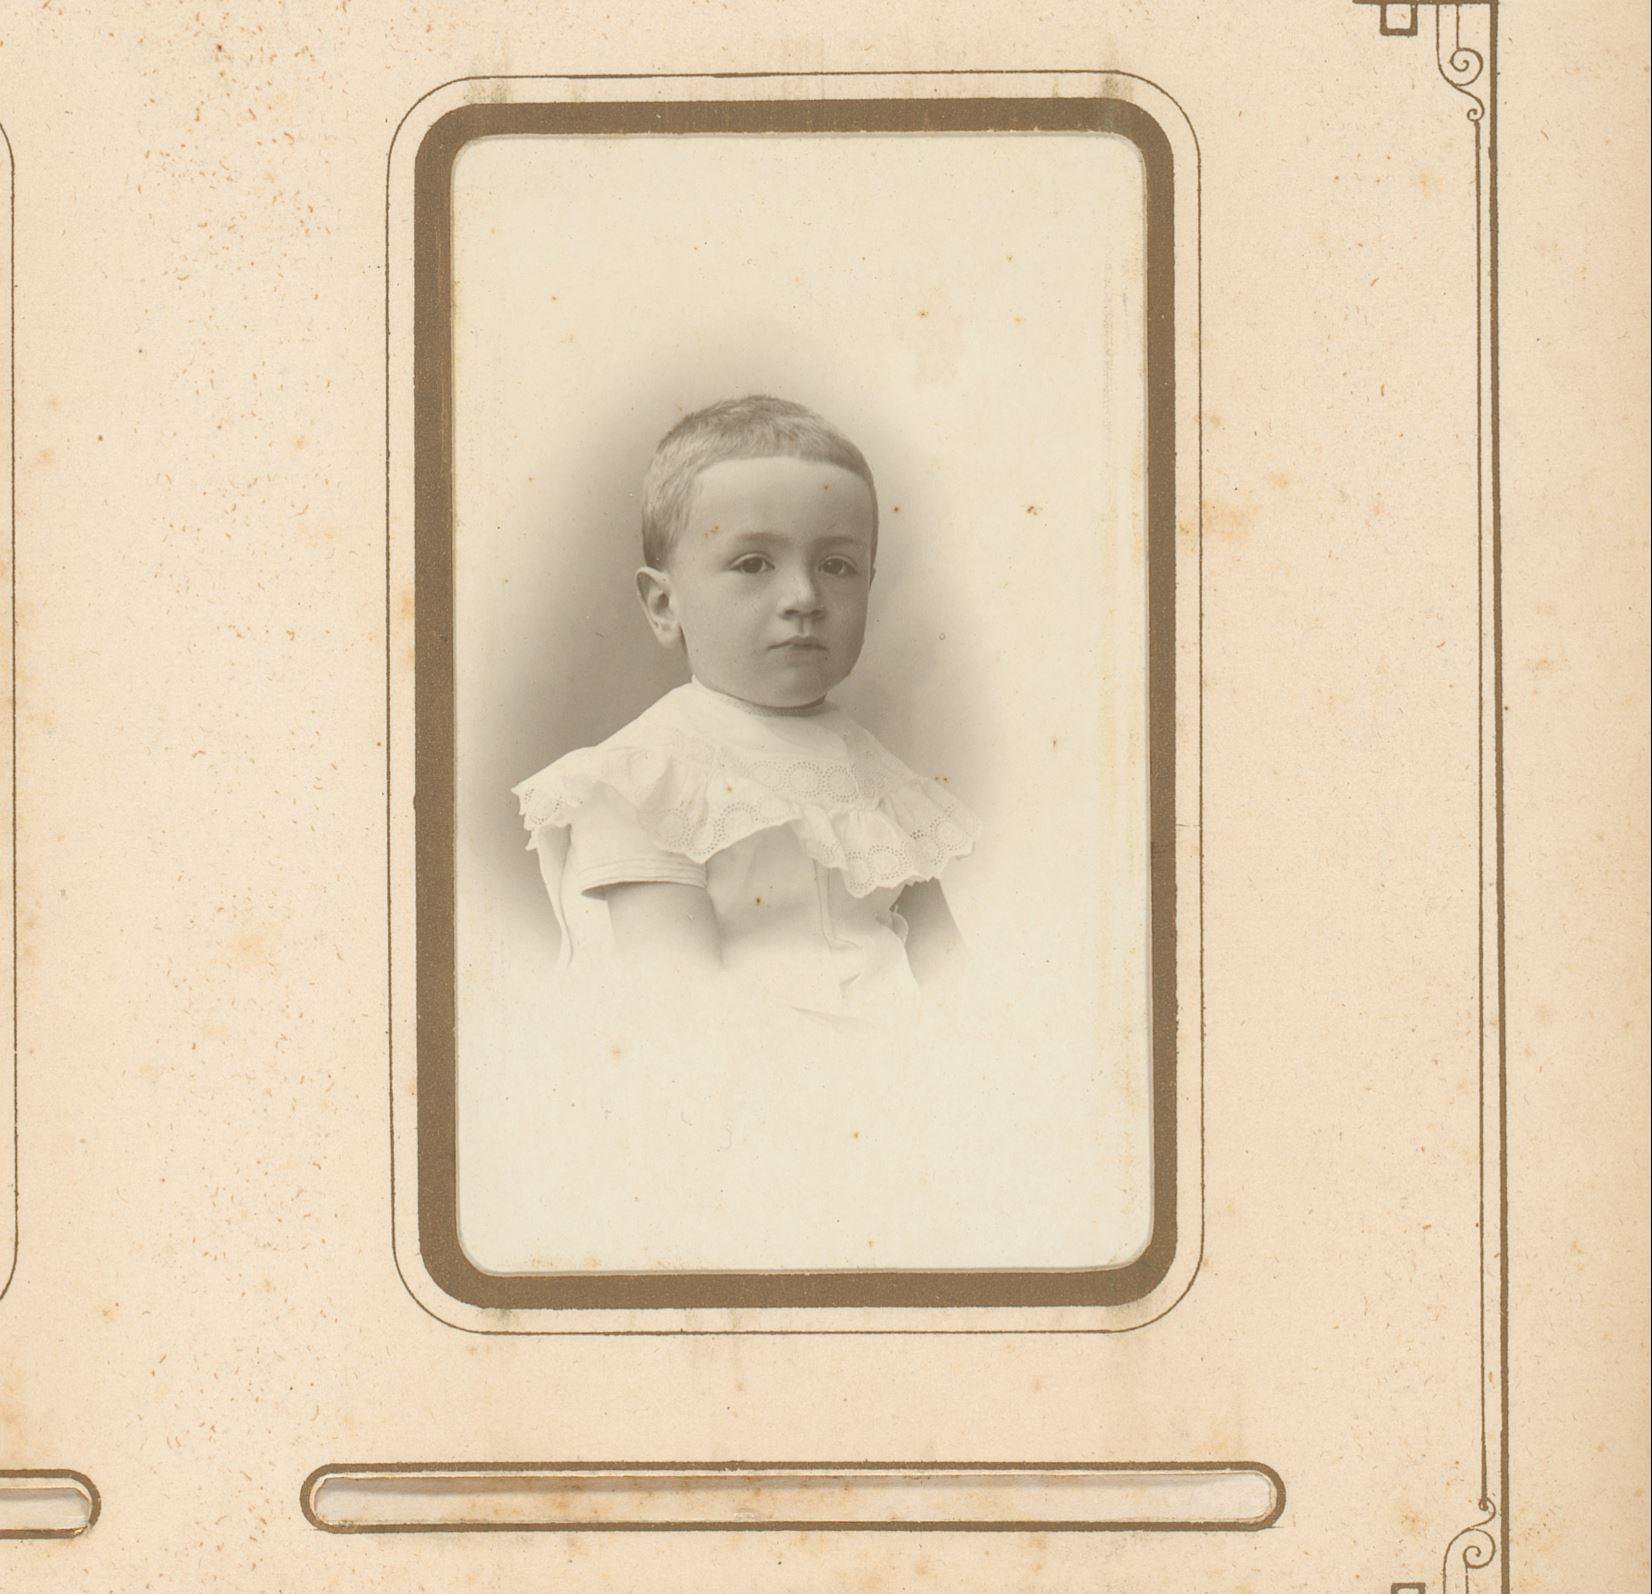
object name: album leaf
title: Portret van een peuter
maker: cornelius antonius gerardus leijenaar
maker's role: fotograaf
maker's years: 1874-1955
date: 1880-1920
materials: cardboard, photographic support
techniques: daylight paper print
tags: toddler, historical persons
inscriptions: inscription: ‘(...)/ C. Leijenaar/ Kruiskade 134/ Rotterdam/ (...)’